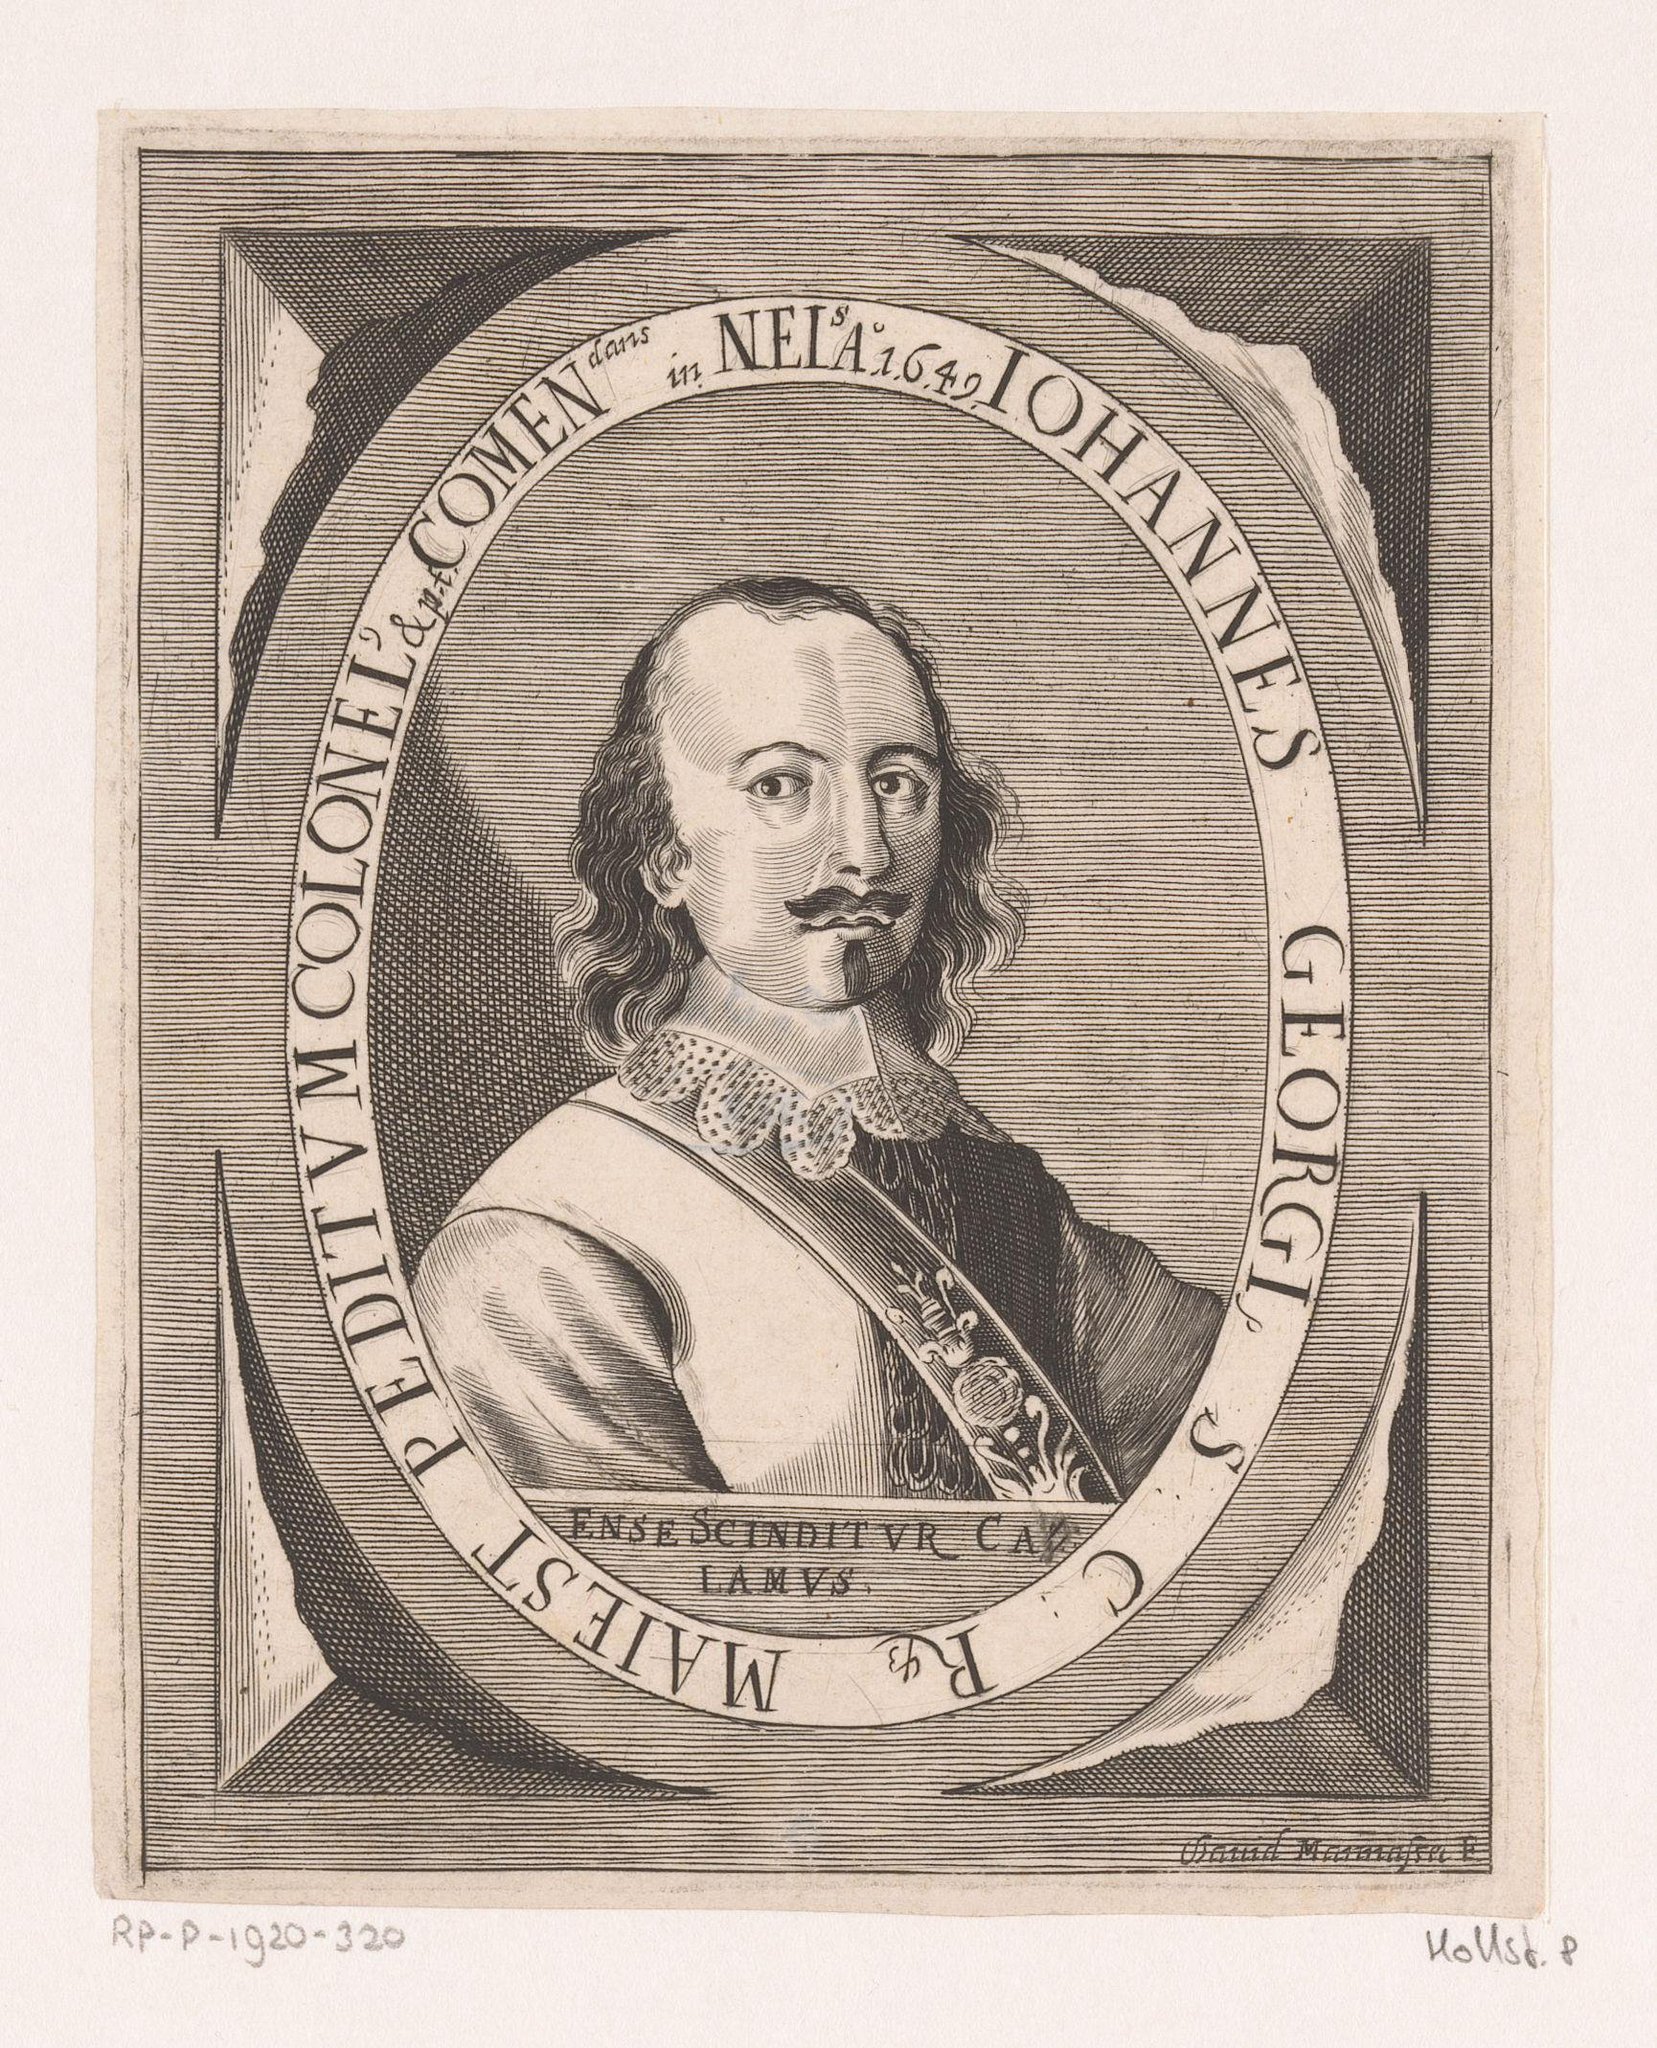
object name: print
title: Portret van Johannes Georgi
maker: david mannasser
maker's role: print maker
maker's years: -1664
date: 1649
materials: paper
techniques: engraving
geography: graz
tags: historical persons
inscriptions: collector's mark: Lugt 2228